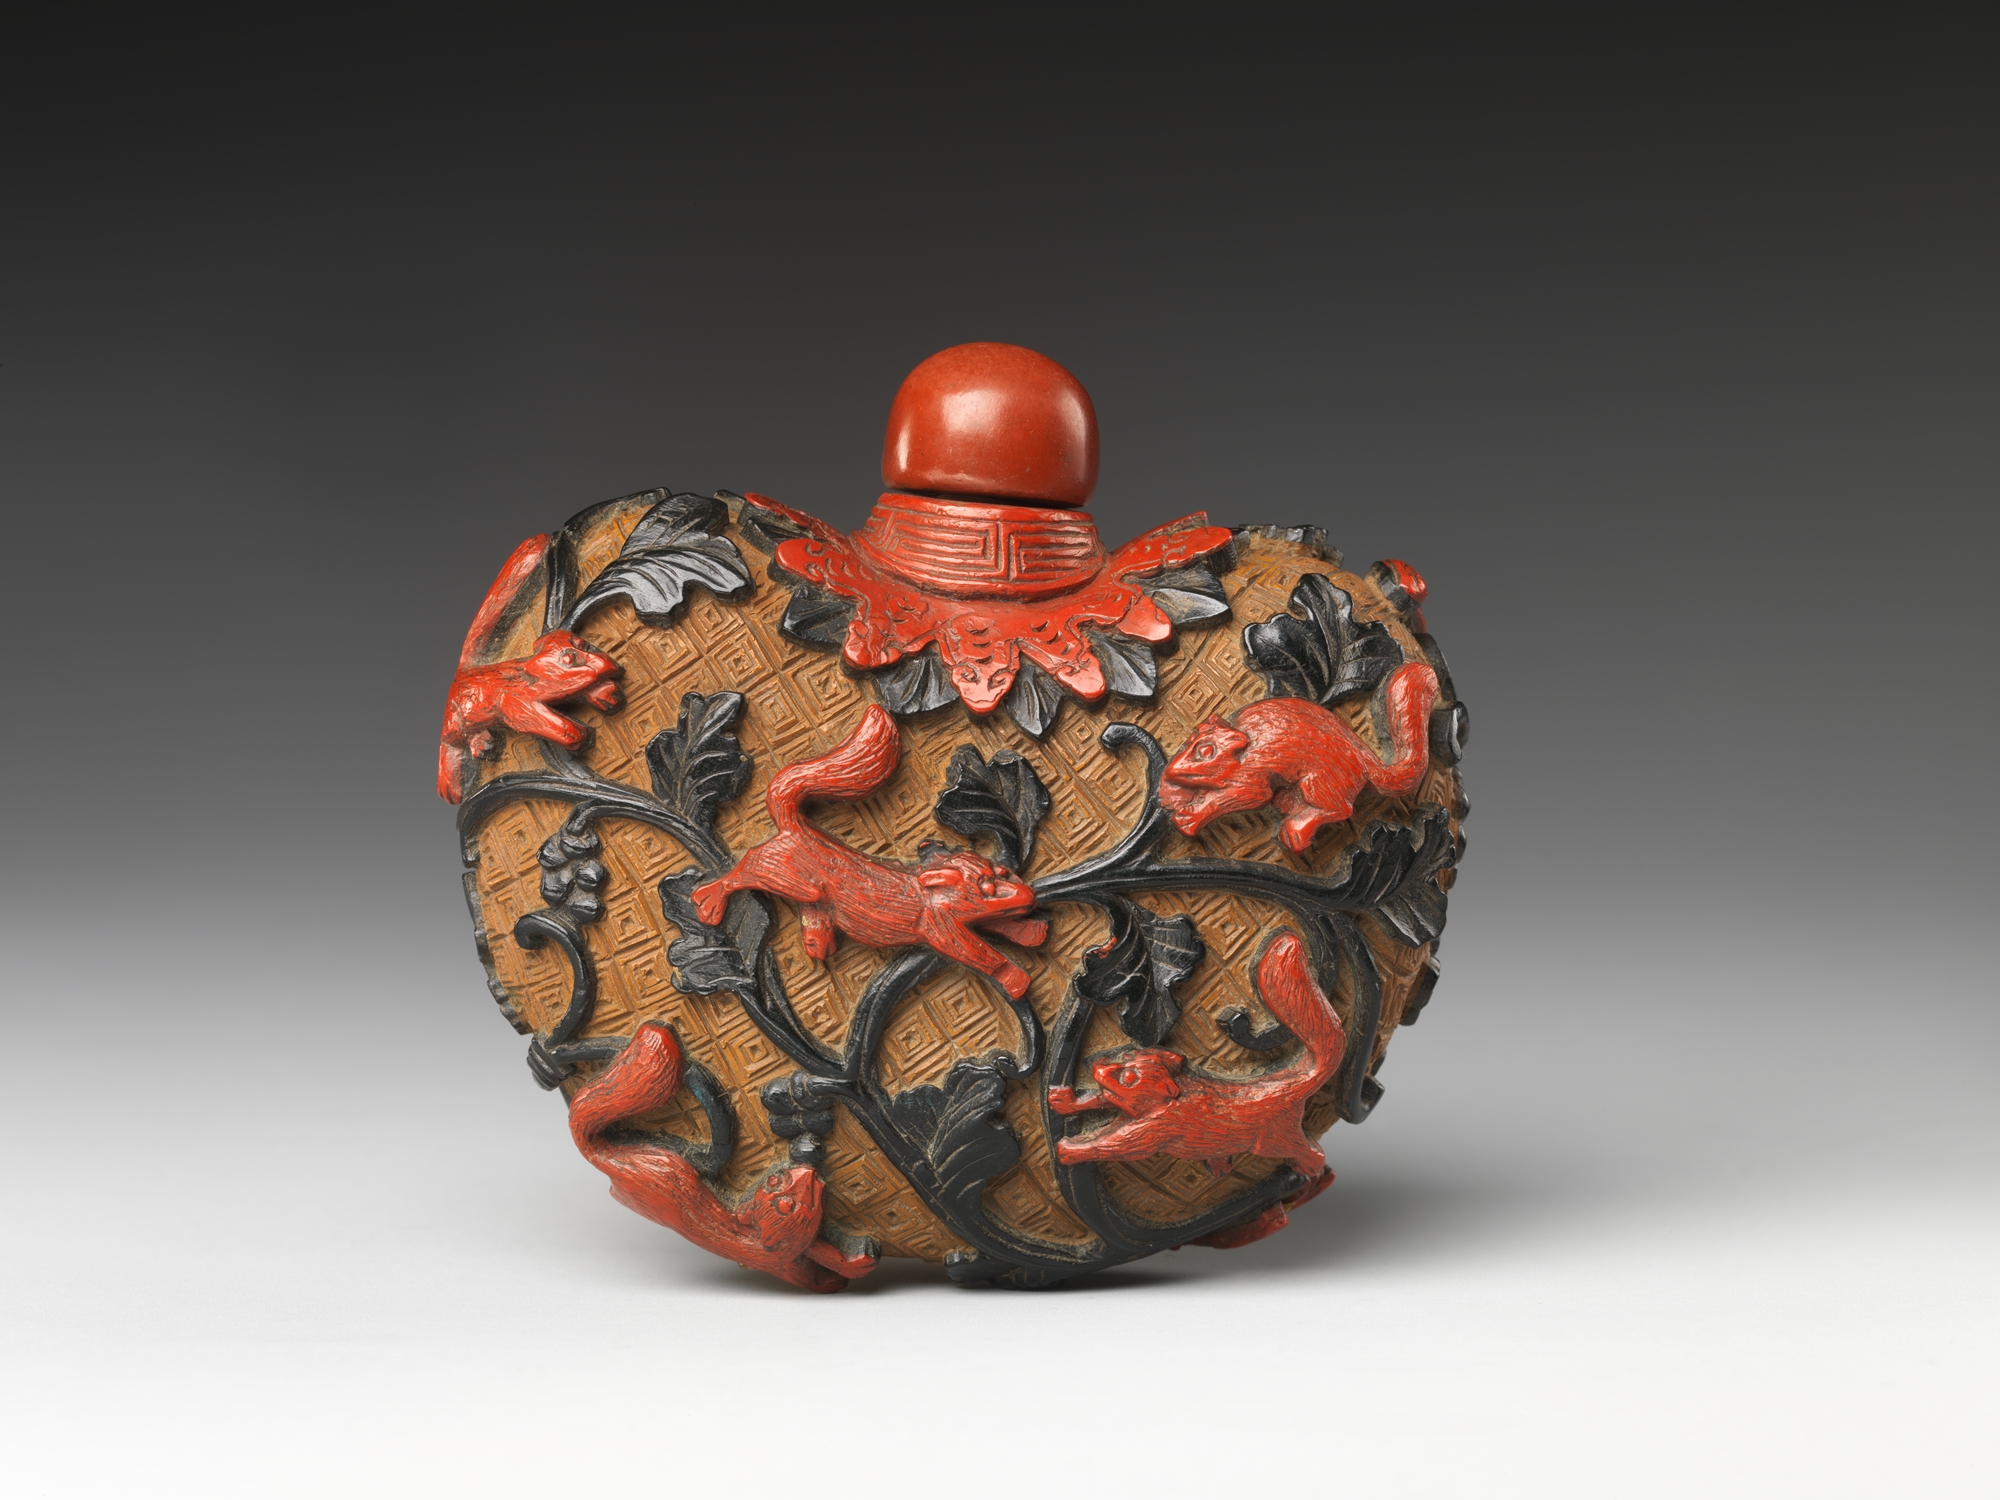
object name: snuff bottle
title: Snuff bottle with squirrels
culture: chinese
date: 1801-1900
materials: lacquer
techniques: carving, polychrome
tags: squirrels